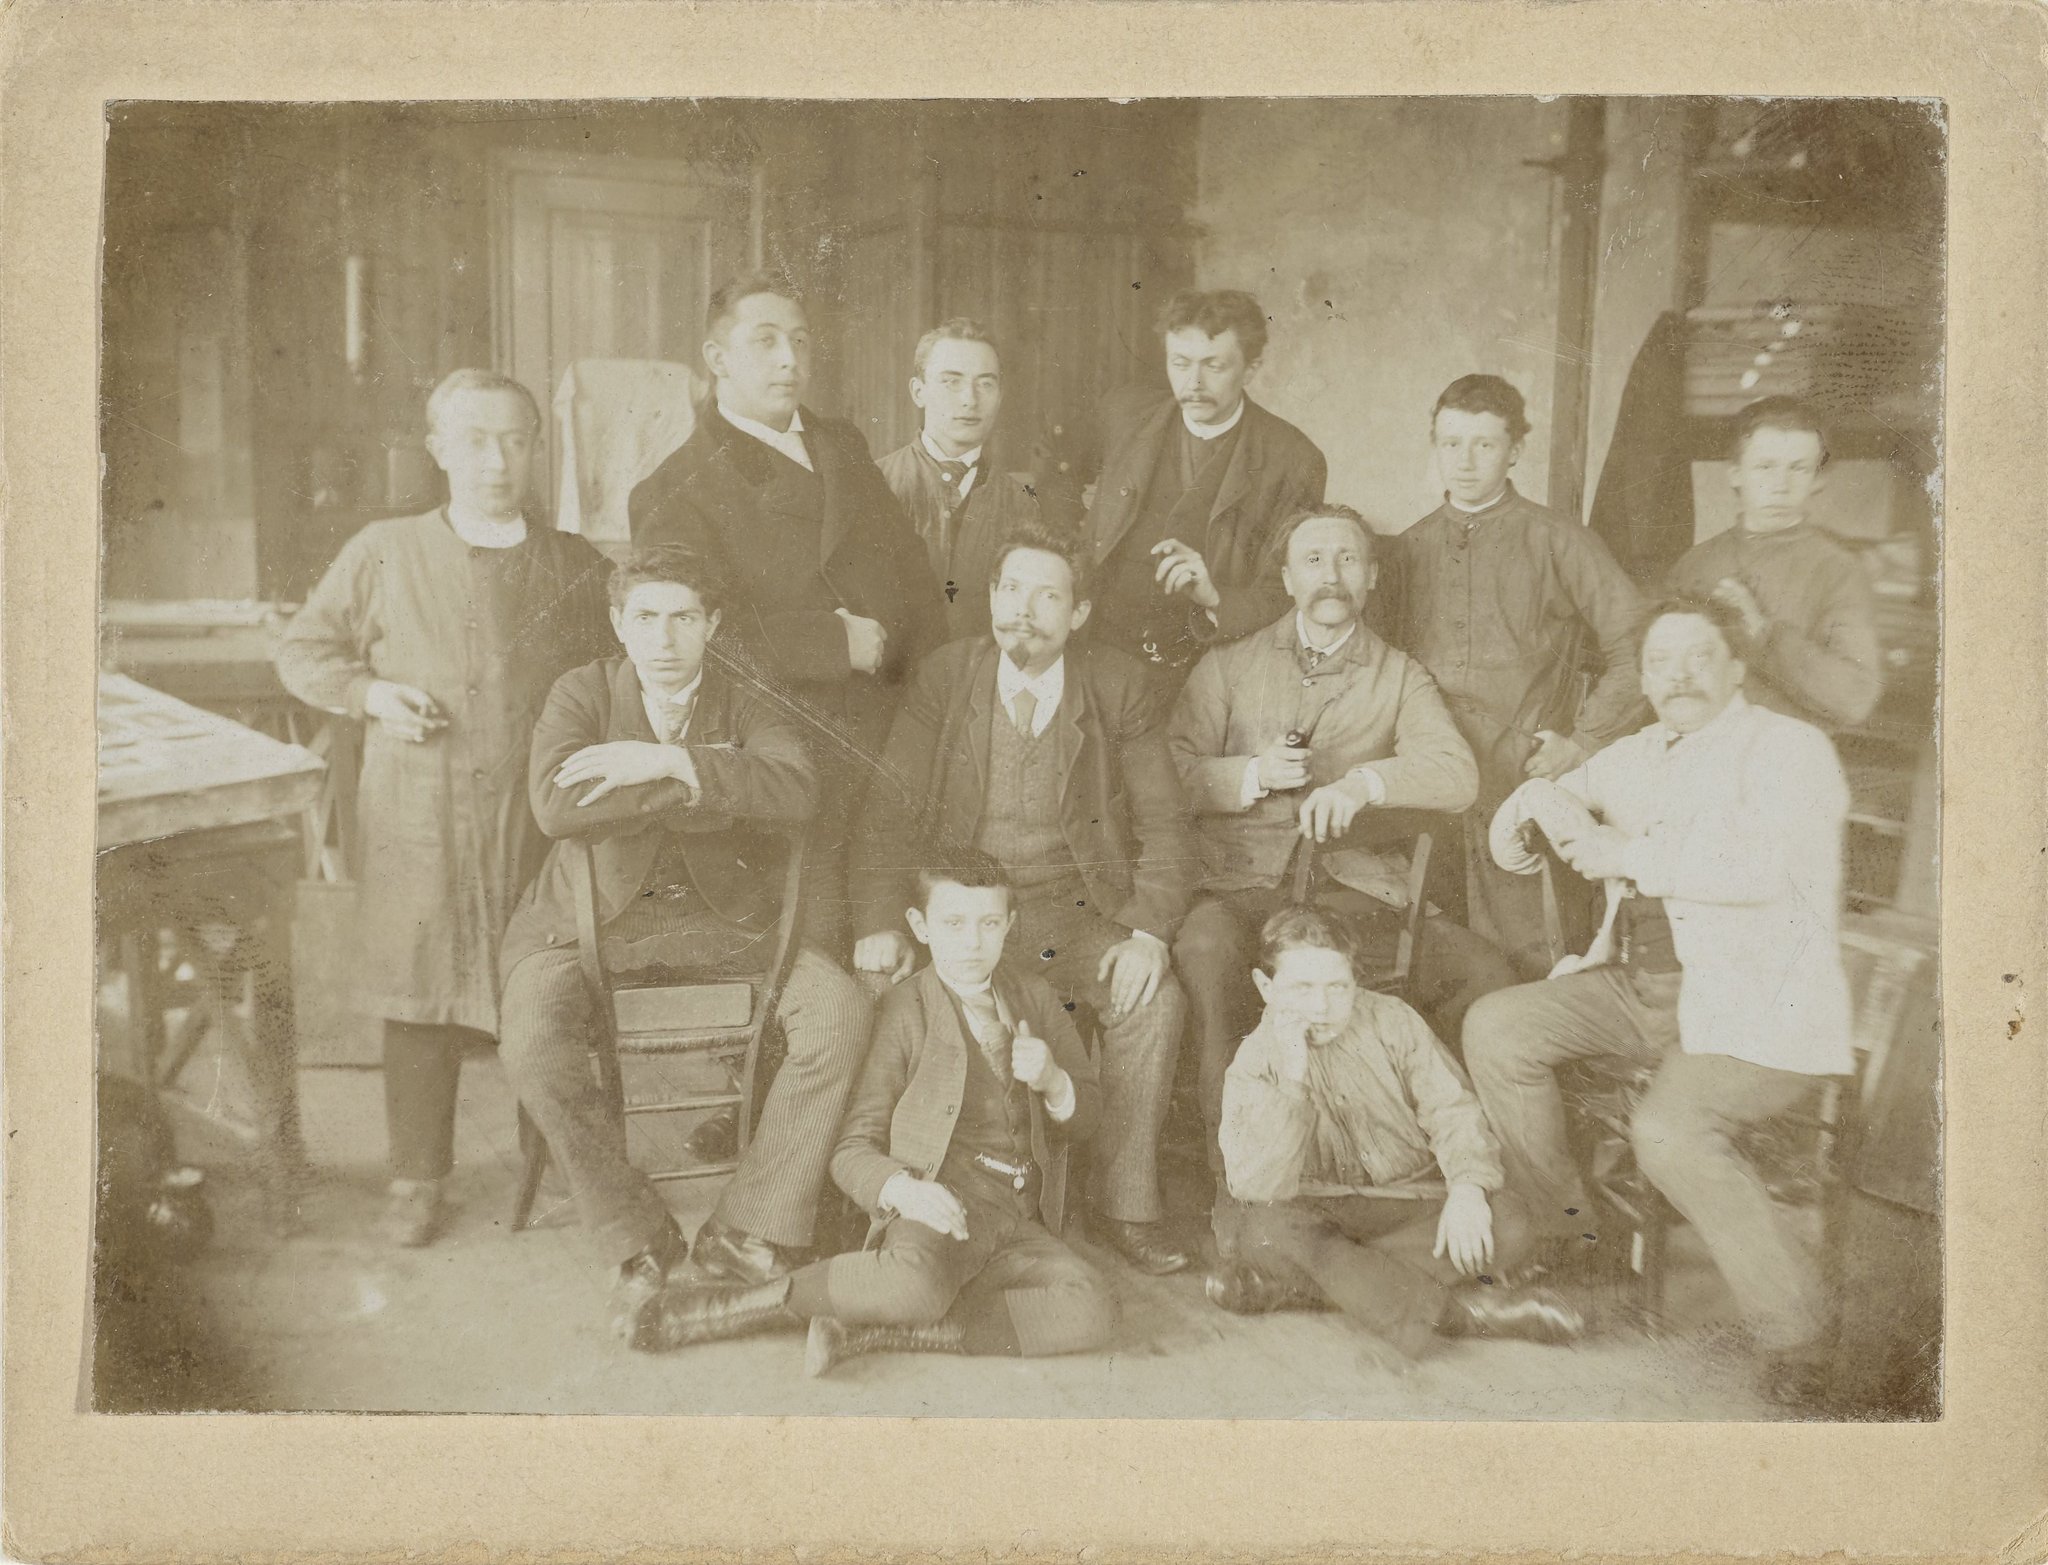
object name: photograph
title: Groepsportret van onbekende werknemers van Steendrukkerij Senefelder te Amsterdam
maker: Anonymous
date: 1900-1910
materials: paper, cardboard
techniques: gelatin silver print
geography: amsterdam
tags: printing, printing office, anonymous historical persons portrayed in a group, in a group-portrait